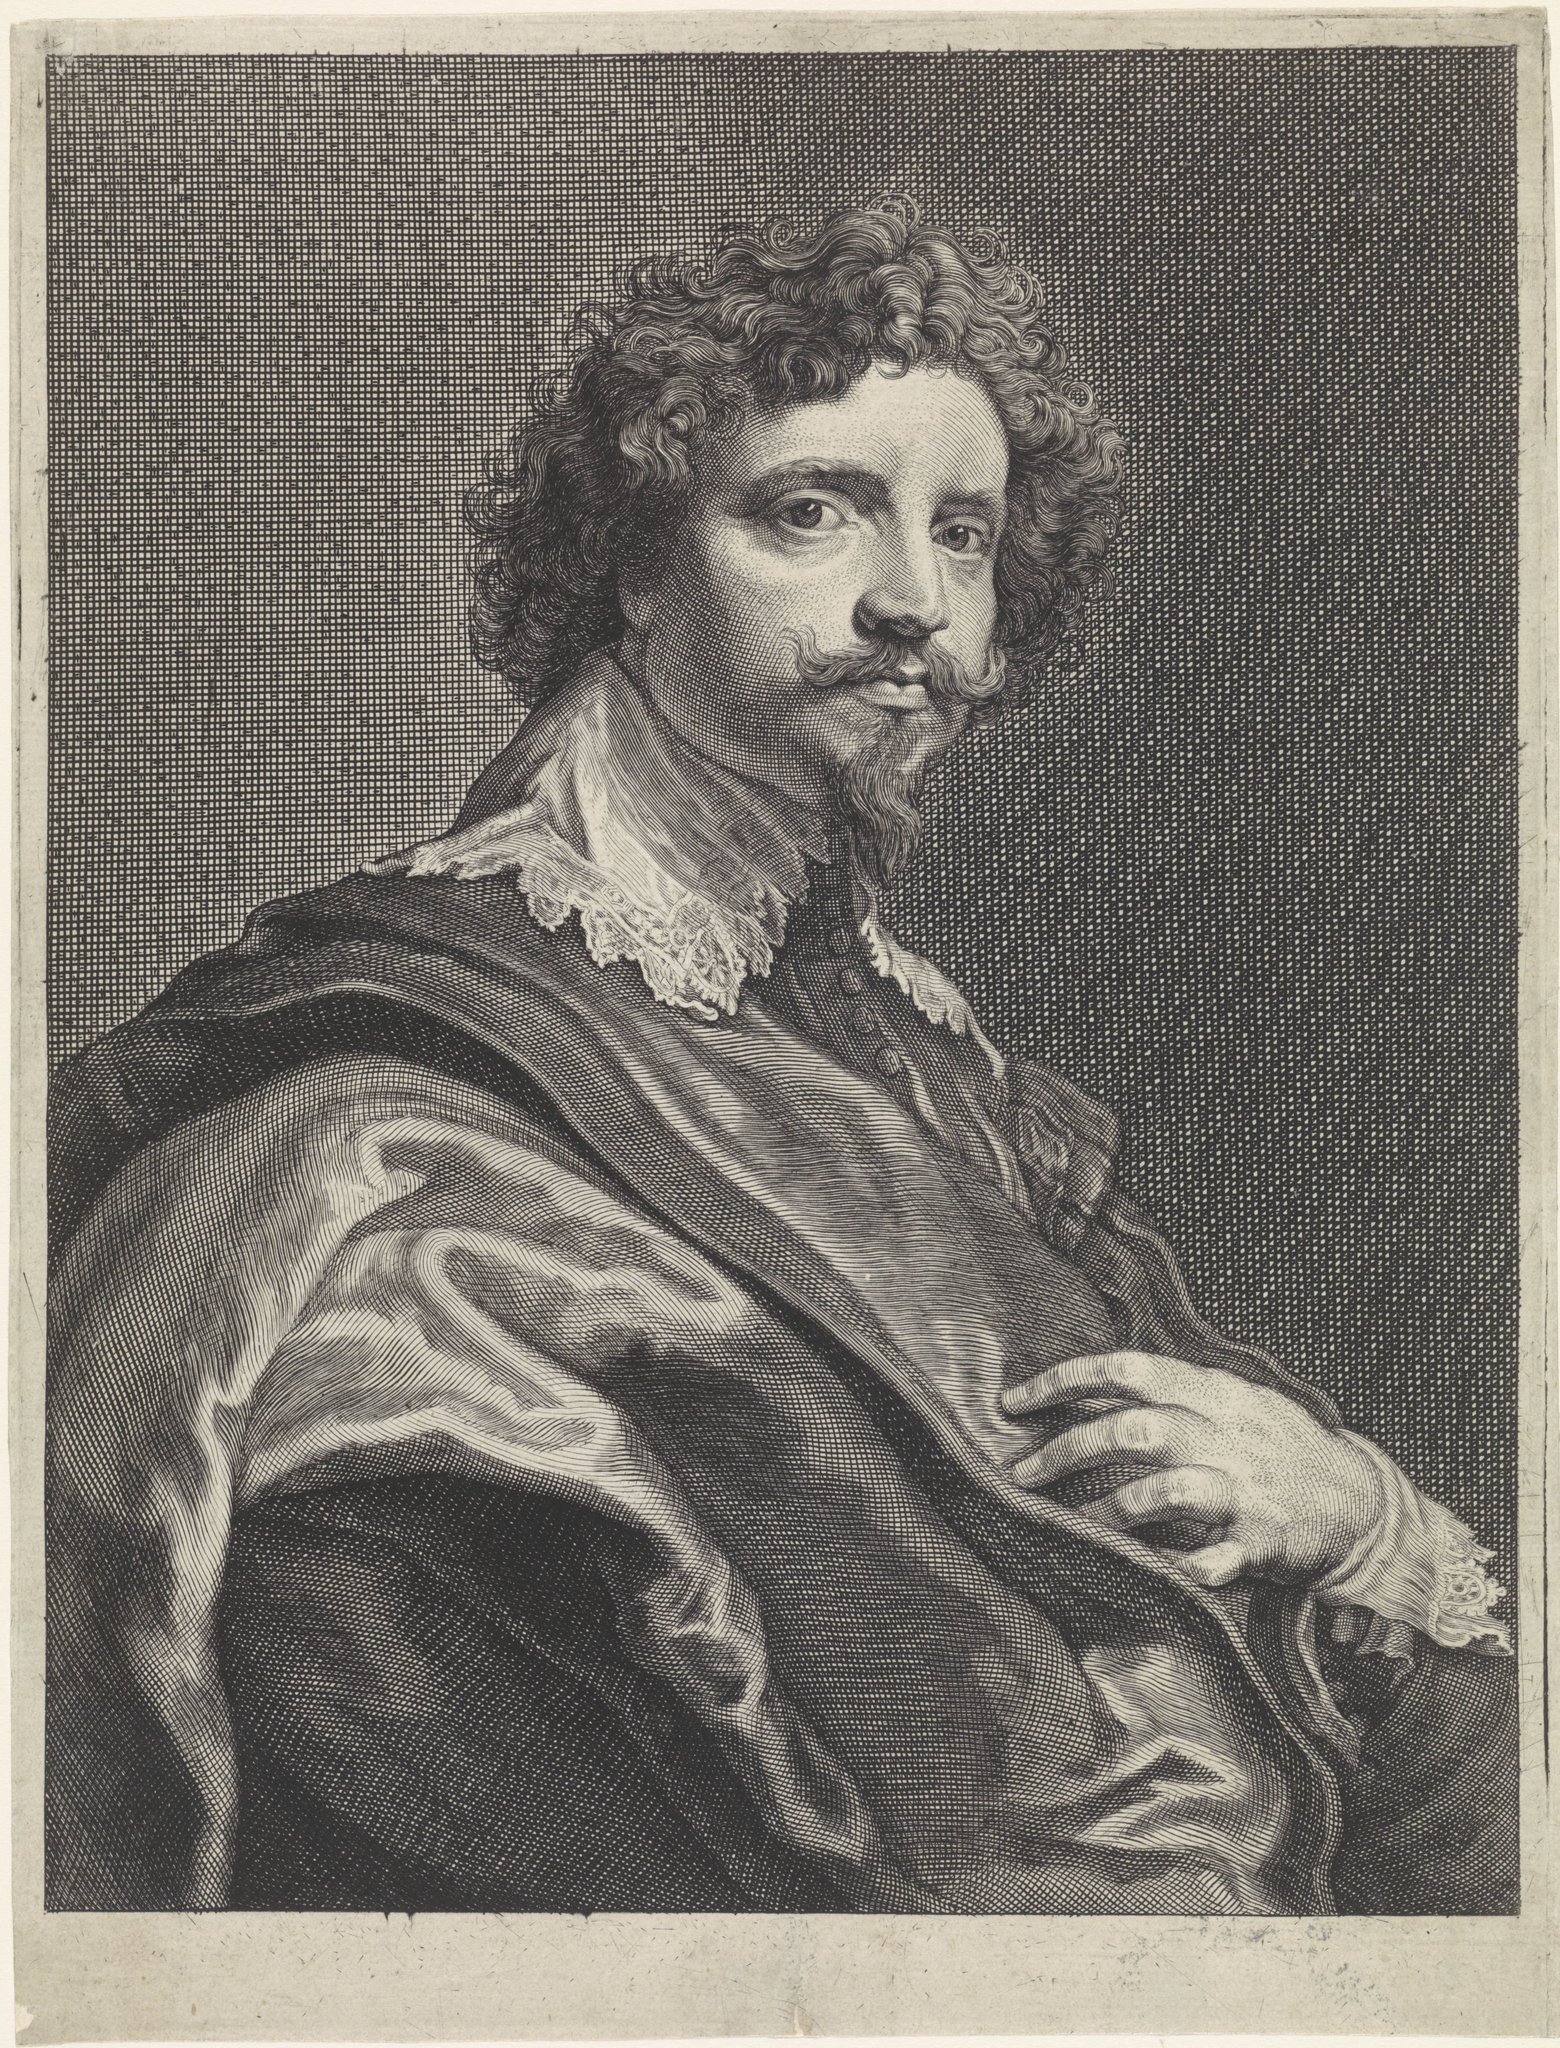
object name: print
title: Portret van Michiel le Blon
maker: theodor matham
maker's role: draughtsman, print maker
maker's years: 1605-1676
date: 1625-1676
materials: paper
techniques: engraving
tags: michiel le blon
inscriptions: collector's mark: Lugt 2228